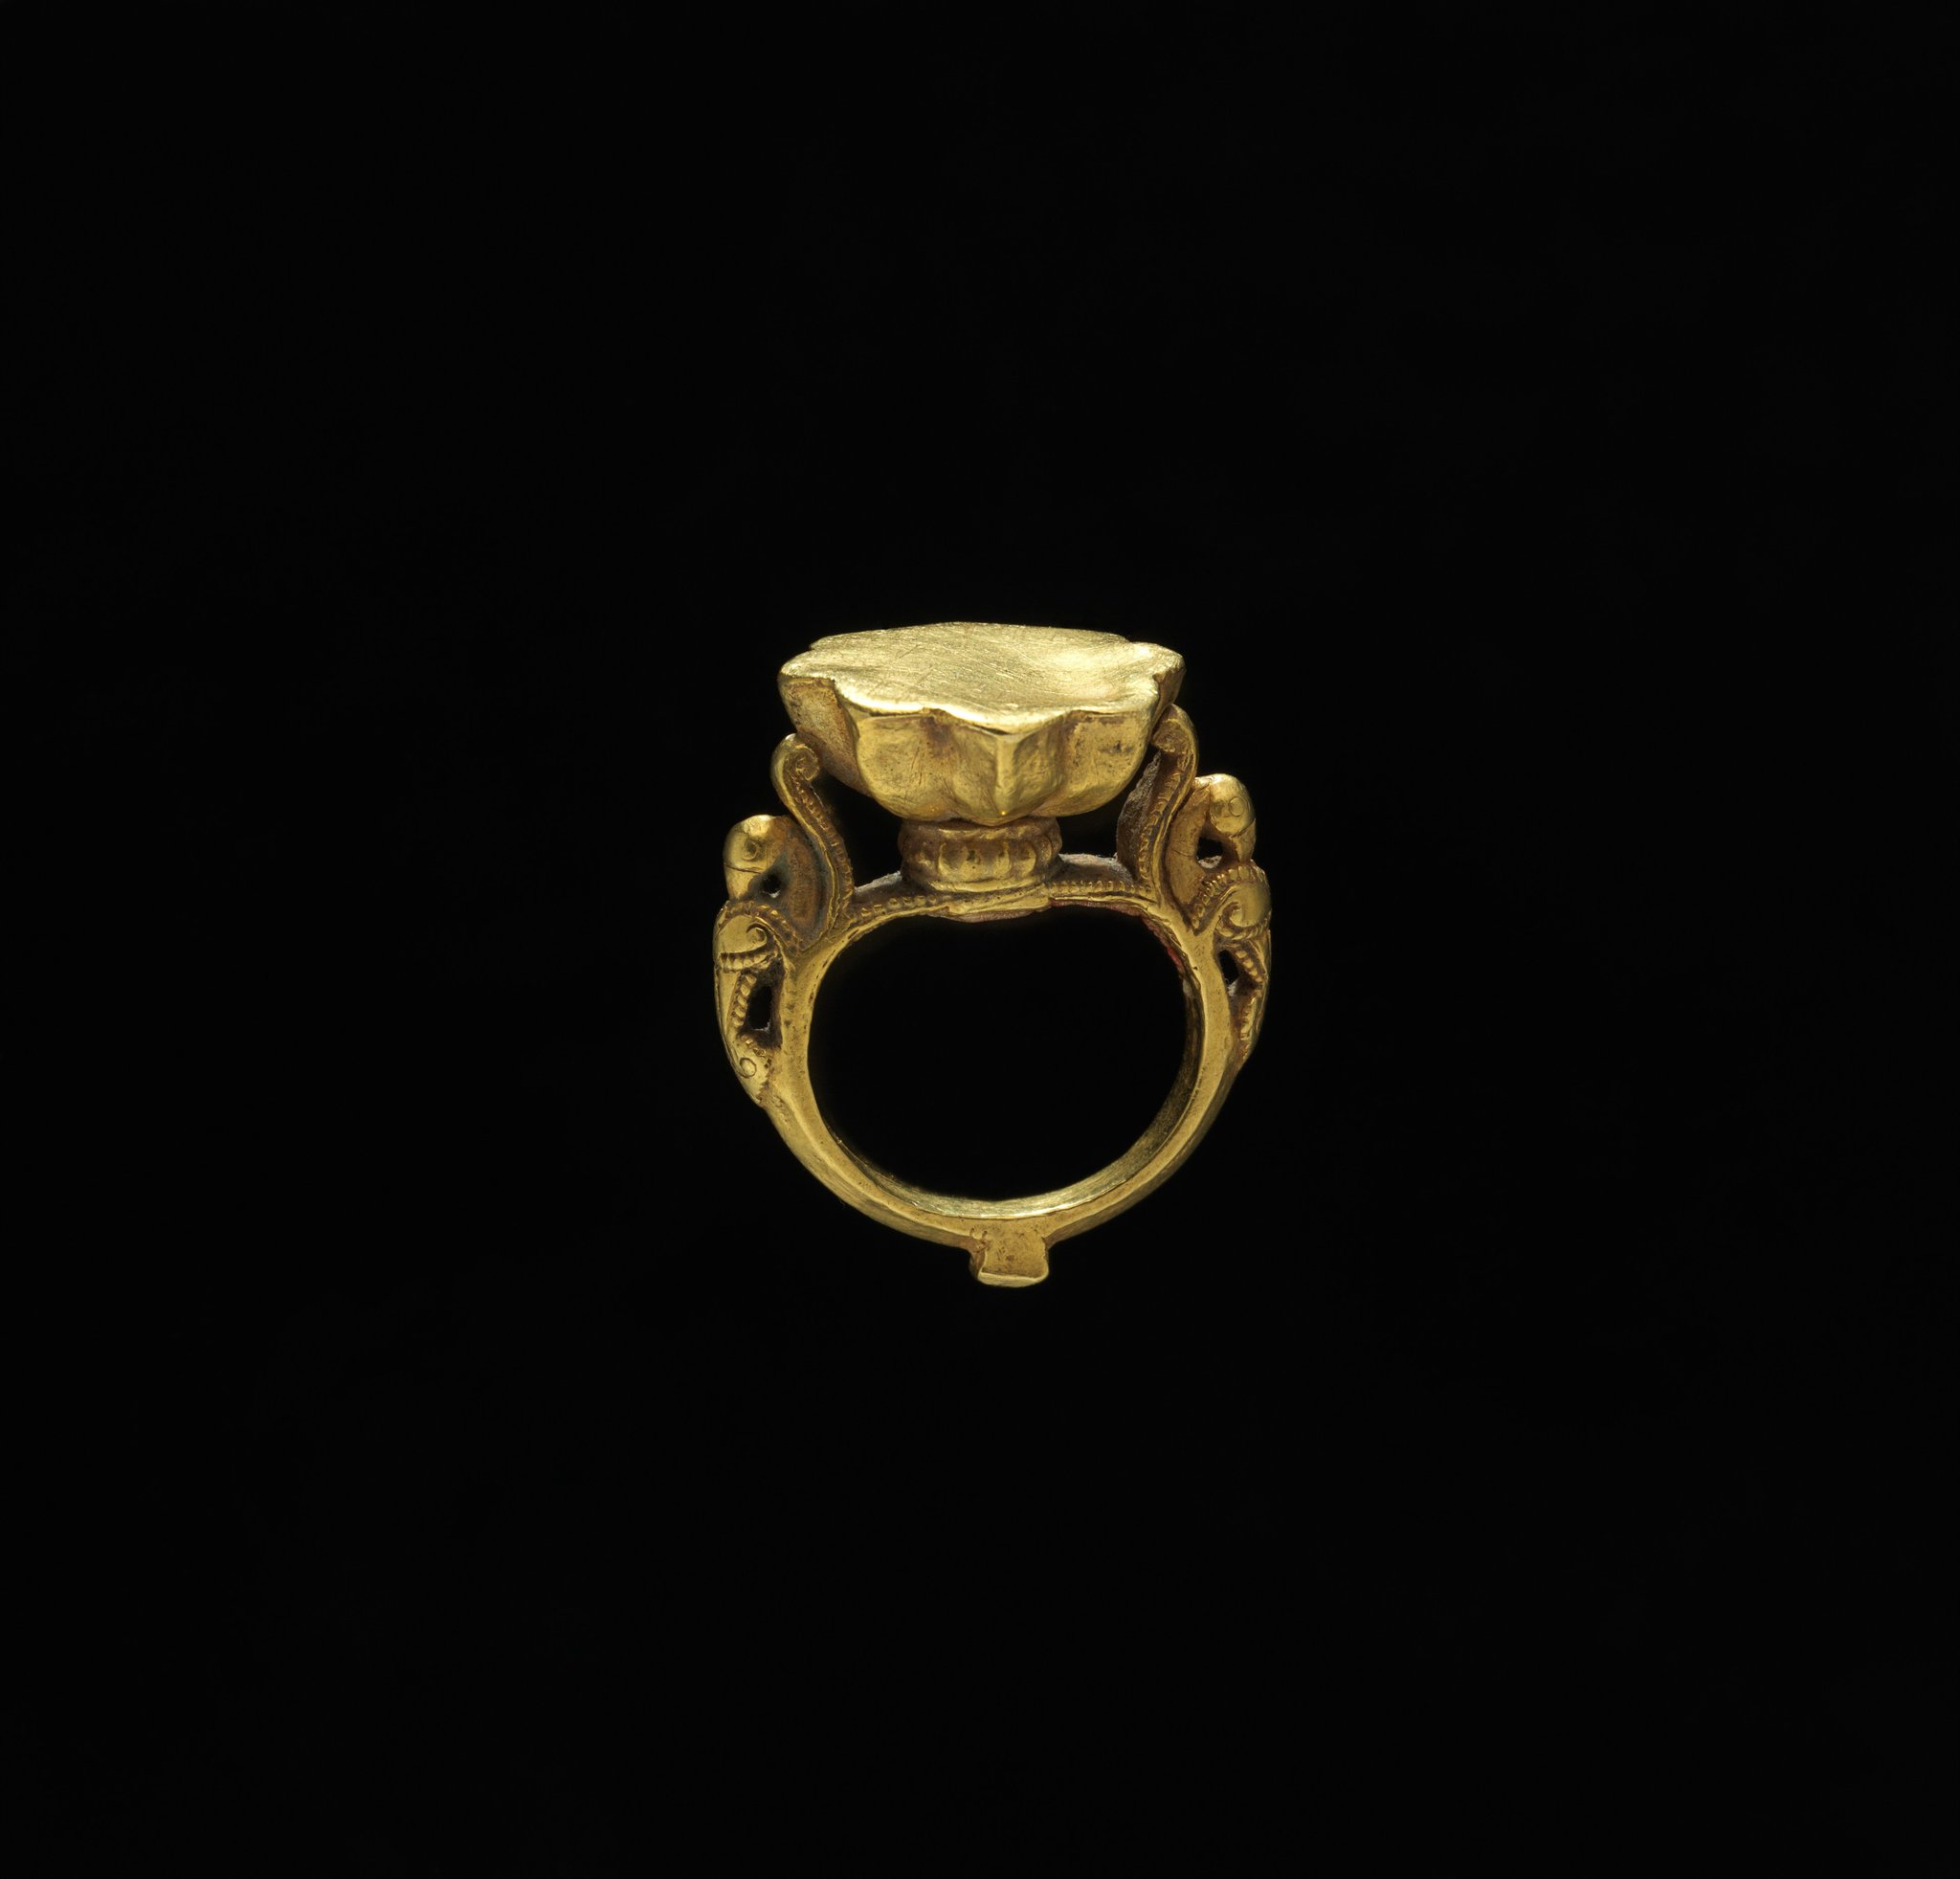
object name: ring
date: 1601-1700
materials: gold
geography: india